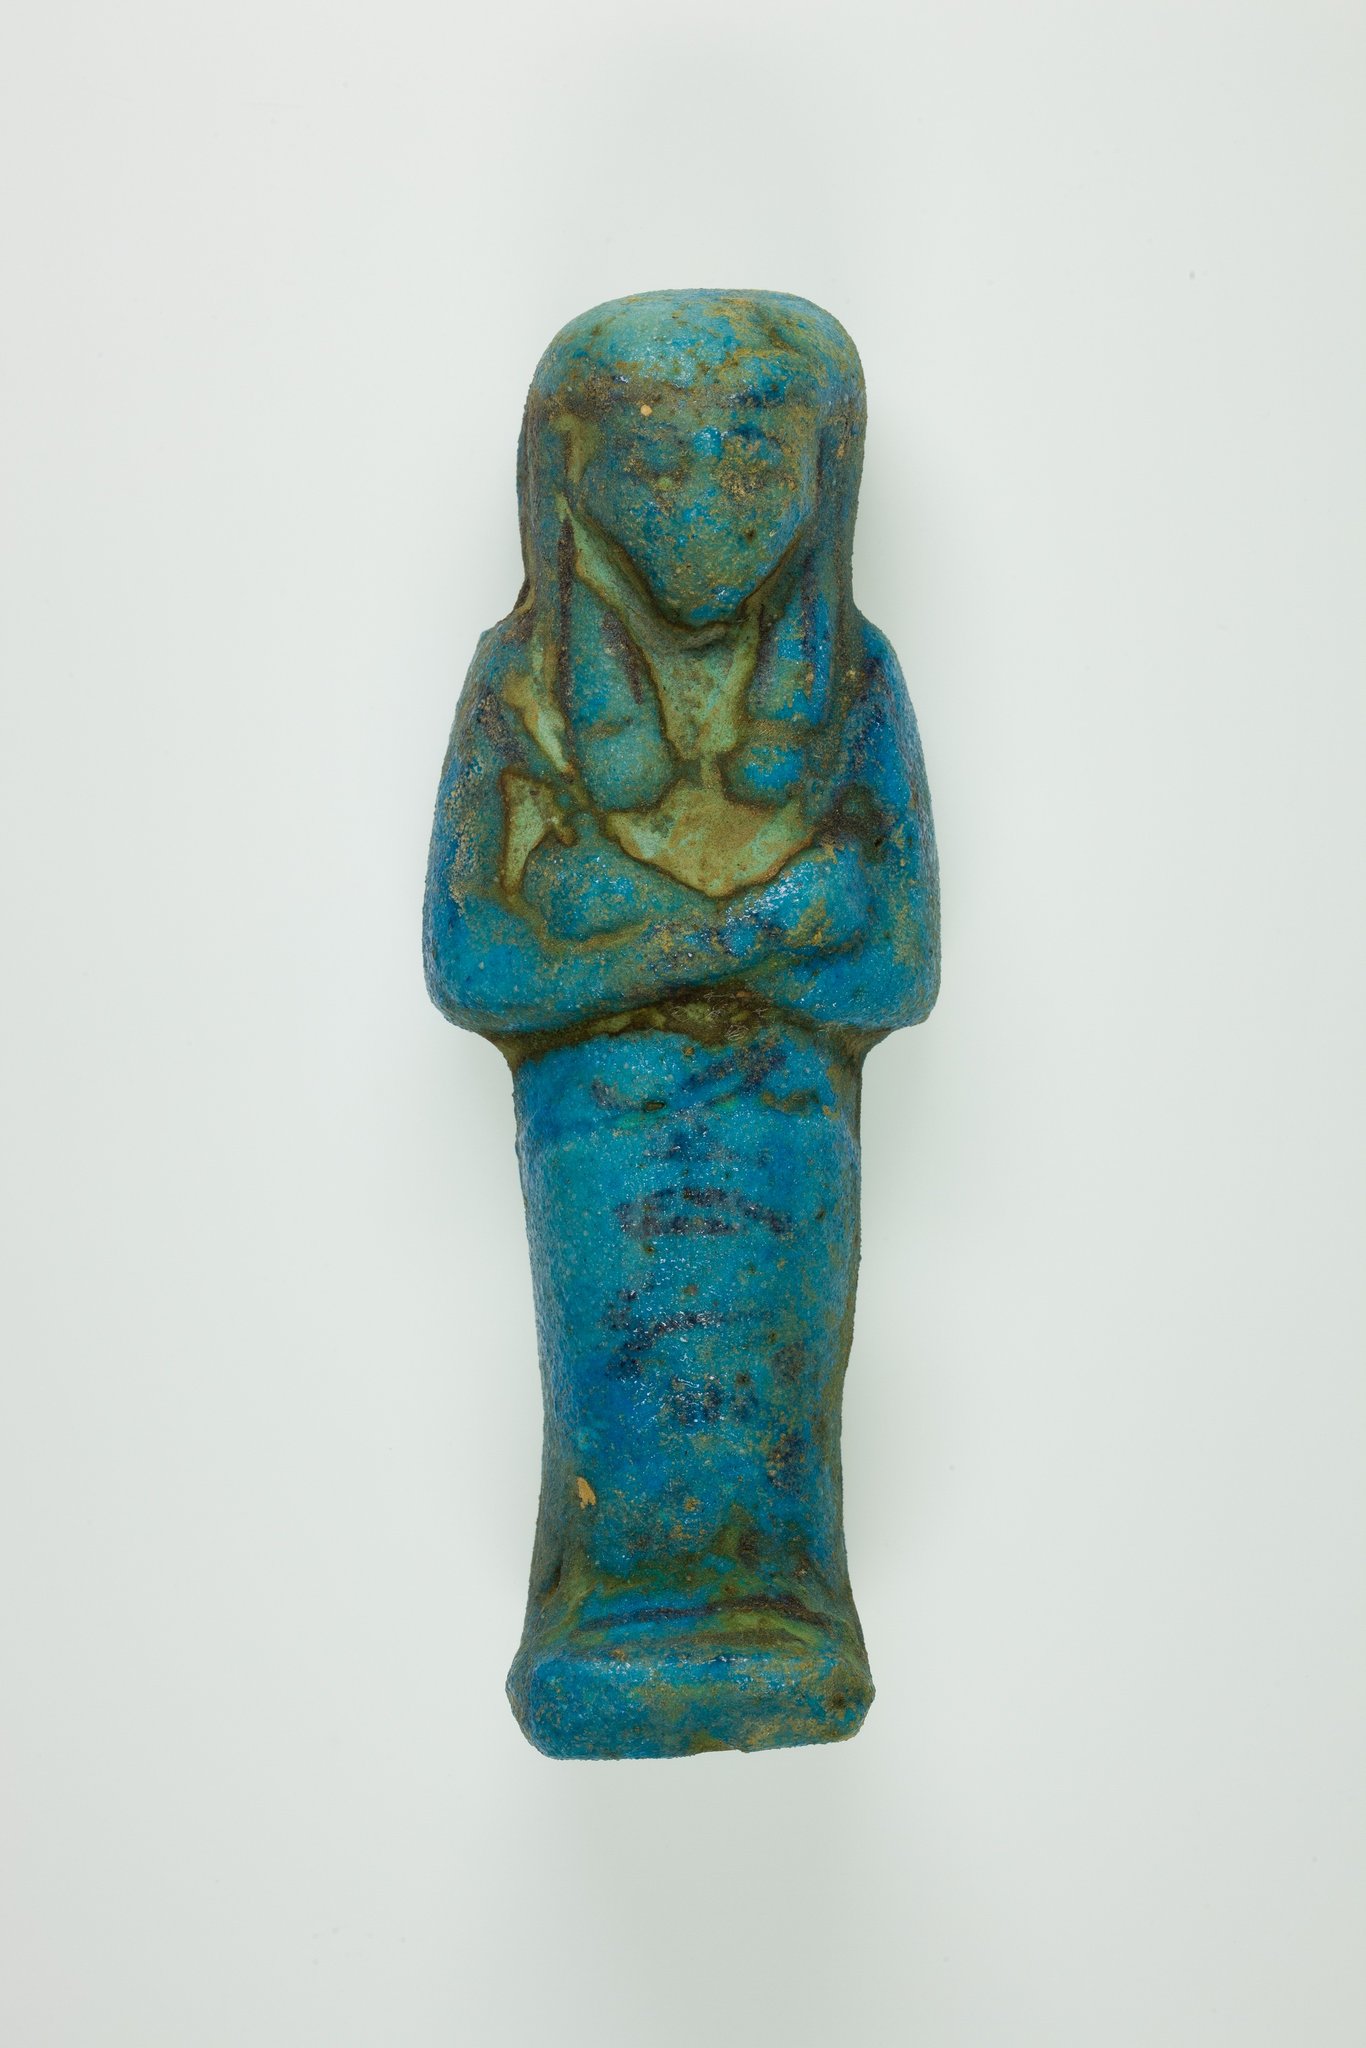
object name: worker shabti, henettawy c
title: Worker Shabti of Henettawy (C), Daughter of Isetemkheb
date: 990-970 BCE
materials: faience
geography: egypt